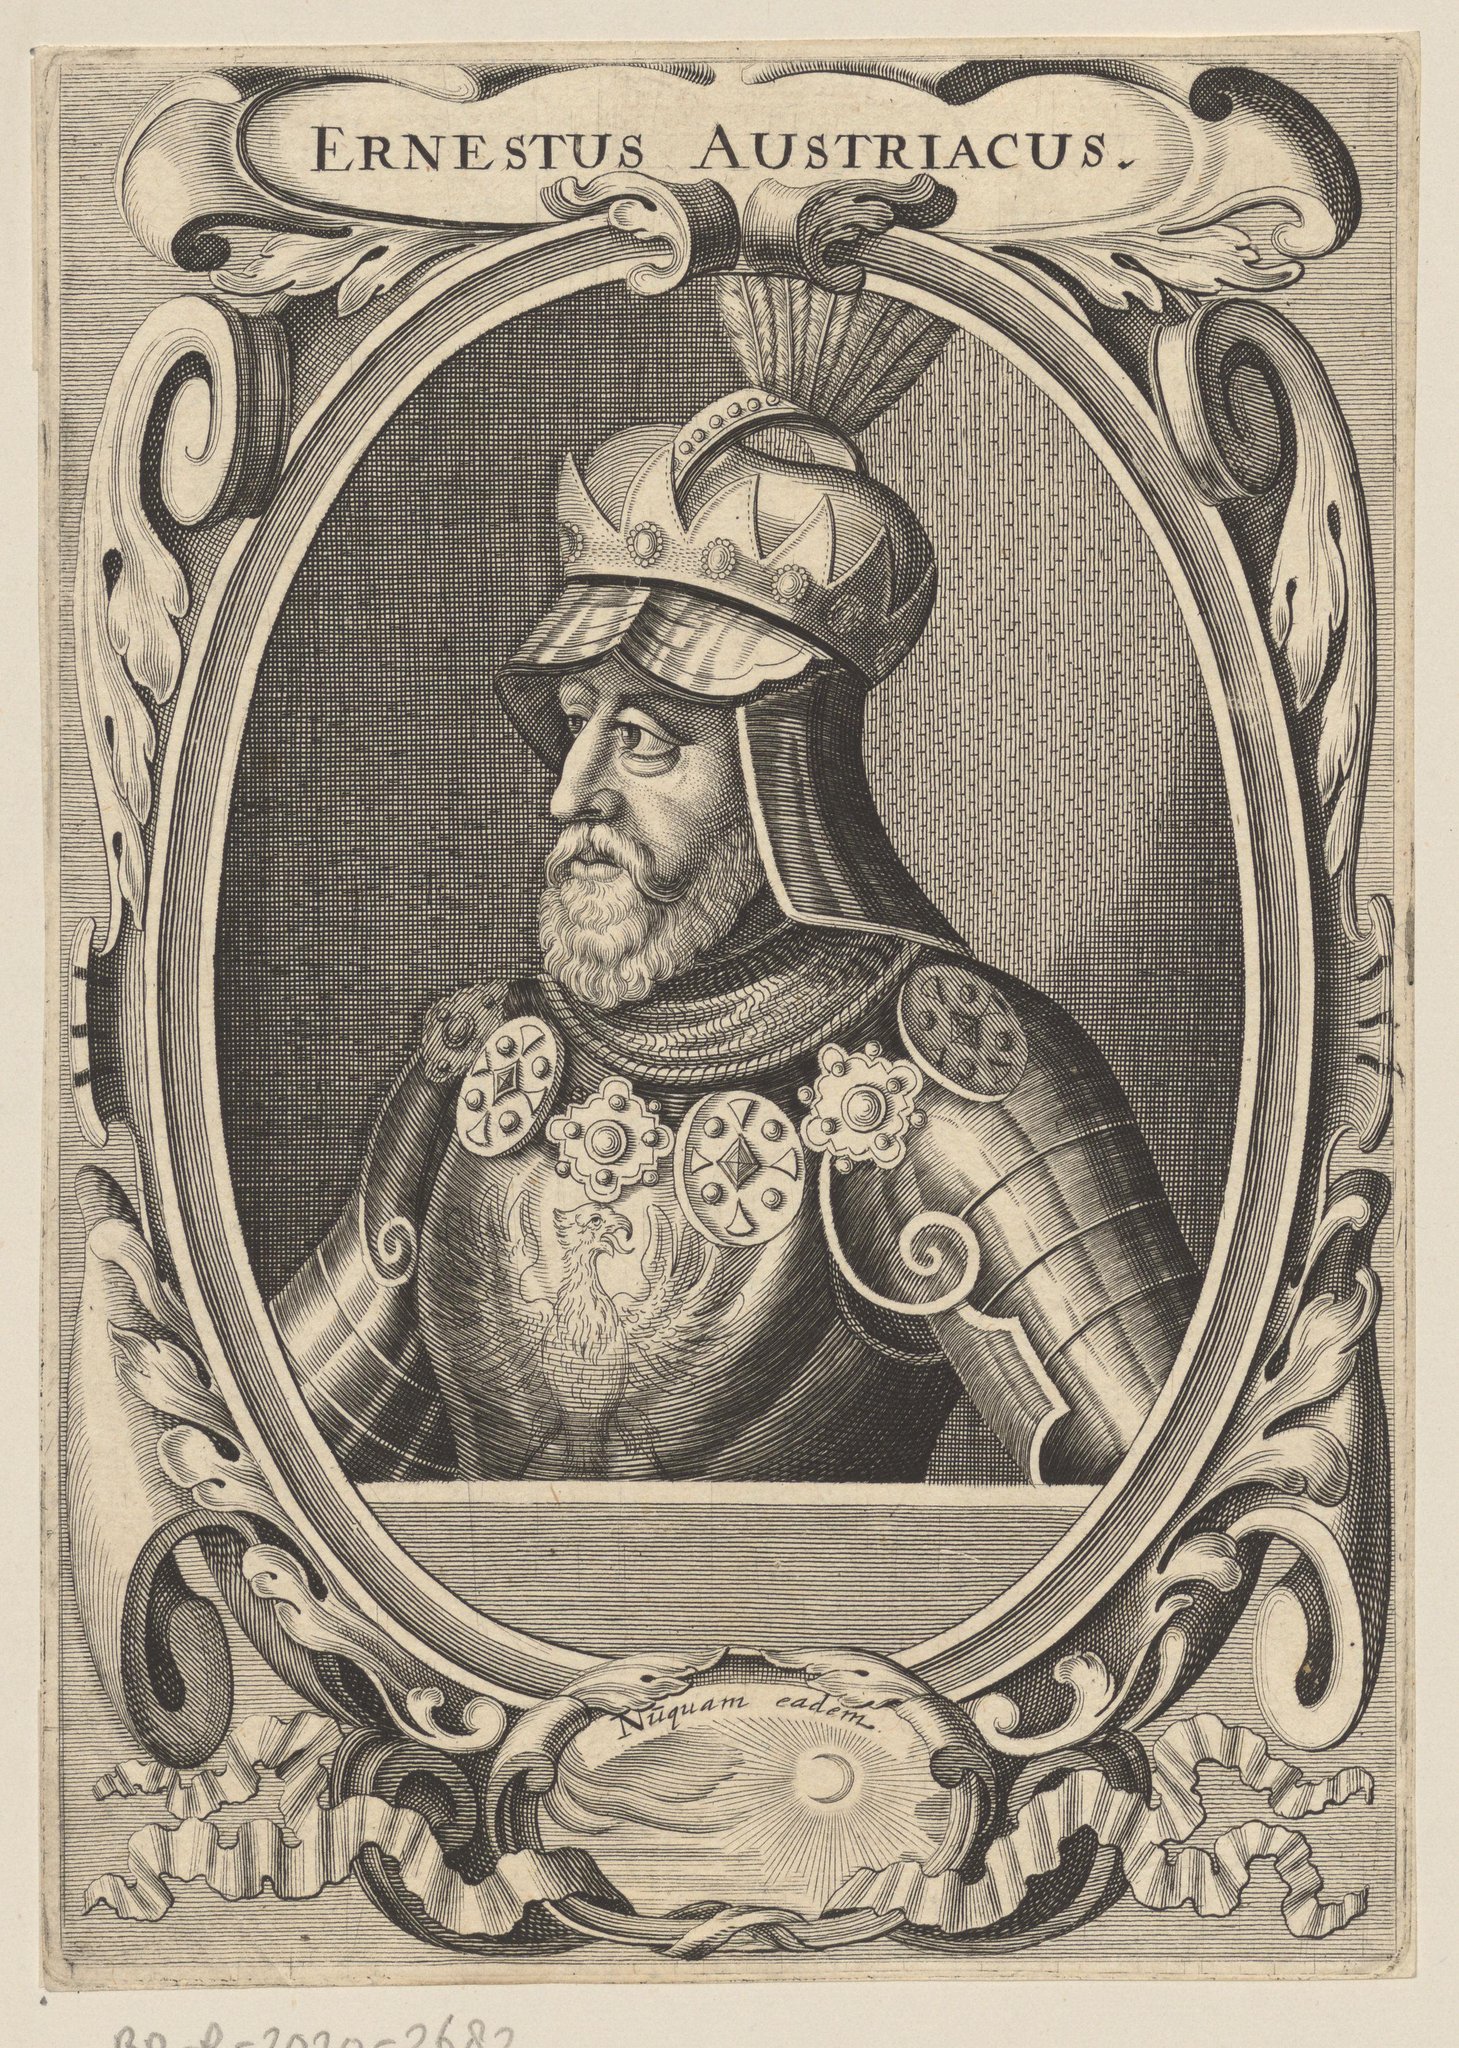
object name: print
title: Portret van Ernst I van Oostenrijk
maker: Anonymous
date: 1630-1680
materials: paper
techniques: engraving, etching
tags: armour, historical persons